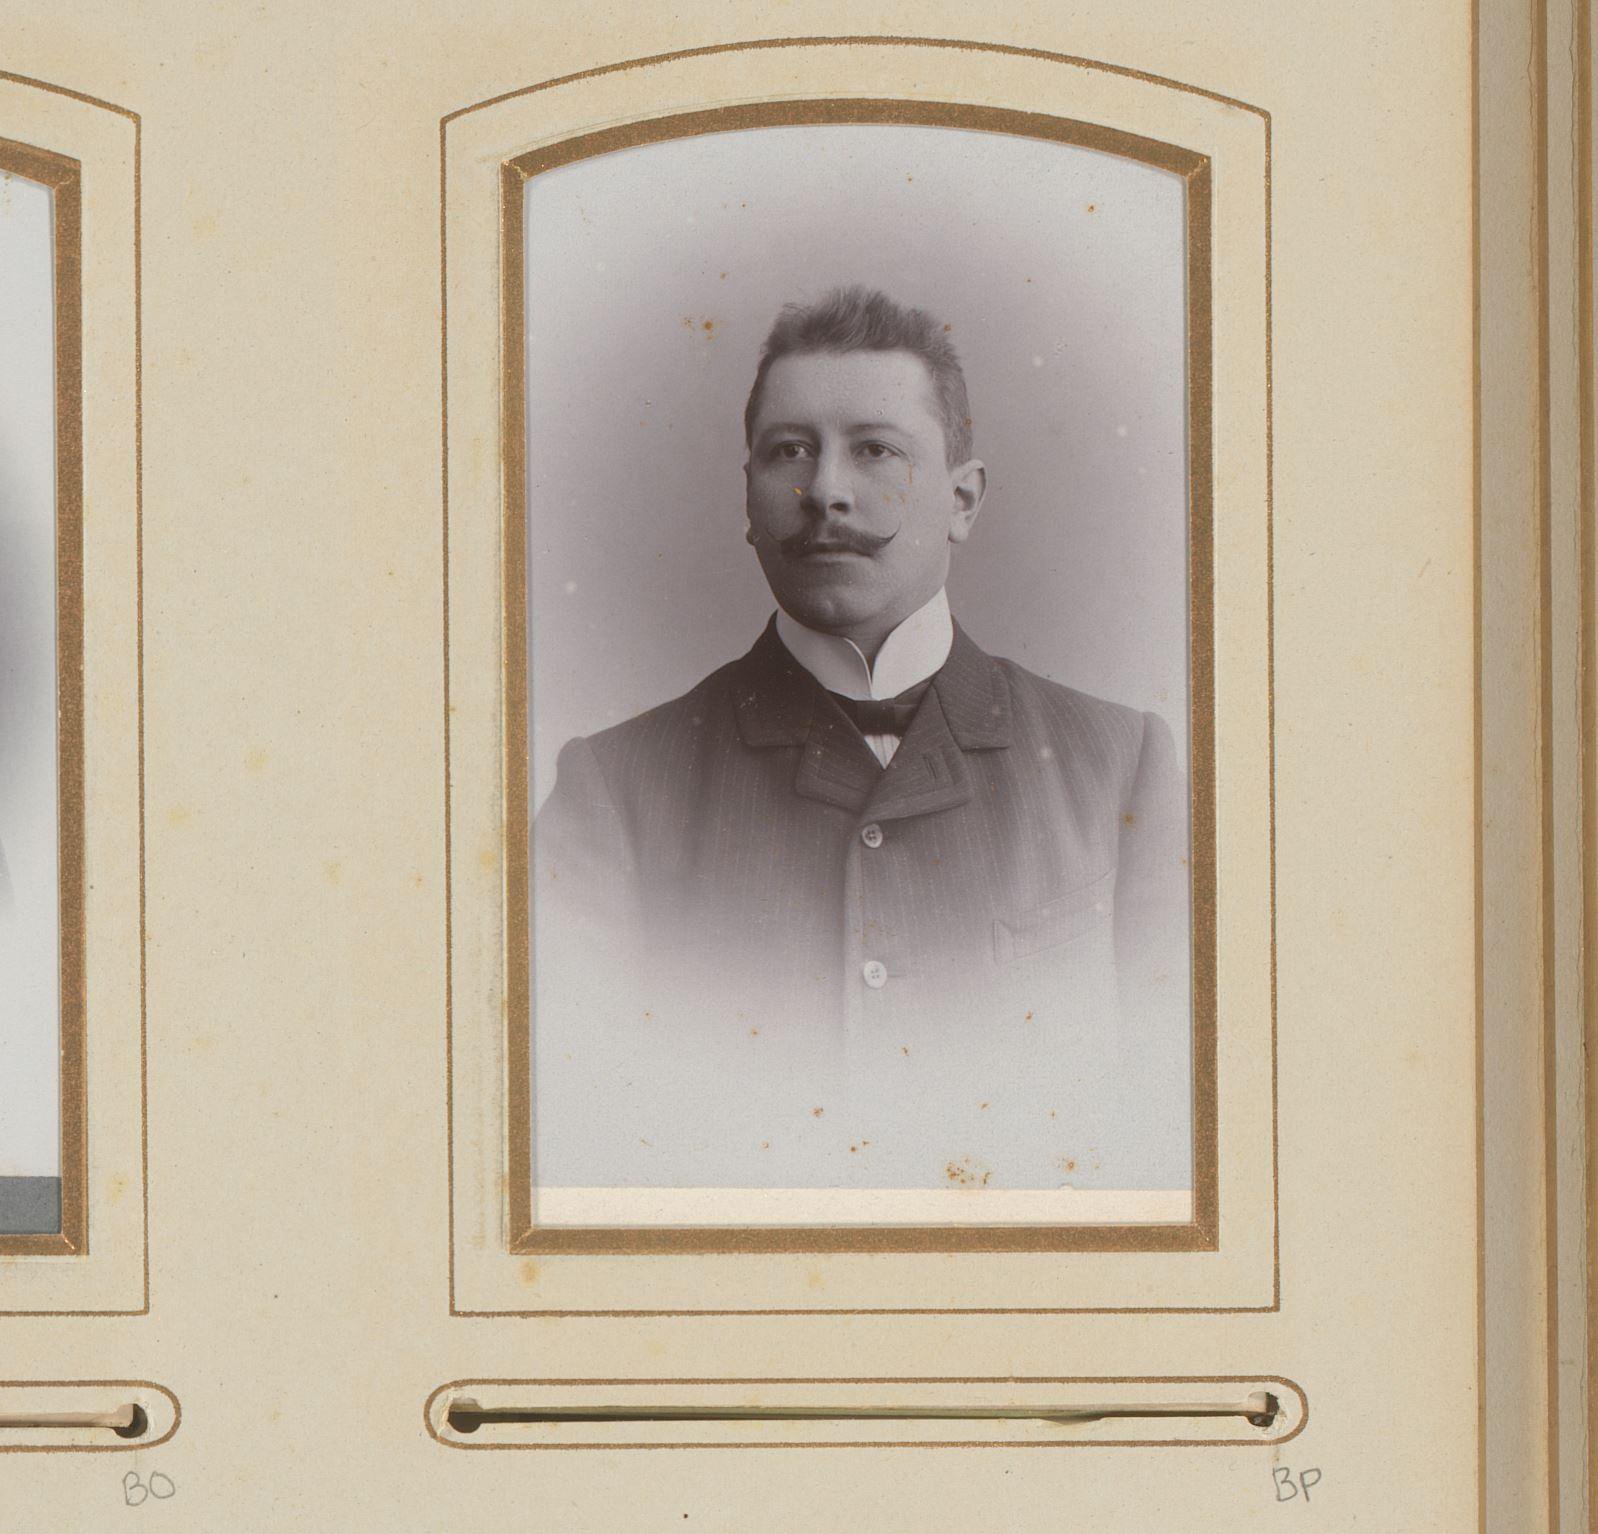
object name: carte de visite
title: Portret van een man met snor en vlinderstrik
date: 1890-1915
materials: cardboard, photographic support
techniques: collodion silver print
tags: moustache, historical persons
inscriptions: inscription: ‘C.J.L. Vermeulen/ den Haag/ Toussaintkade 11./ Intercommunal Telephoon: 774./ Amsterdam/ Heiligenweg hoek Singel./ Telephoon No 2340./ Utrecht/ Nieuwe gracht 50./ Telephoon No 750.’